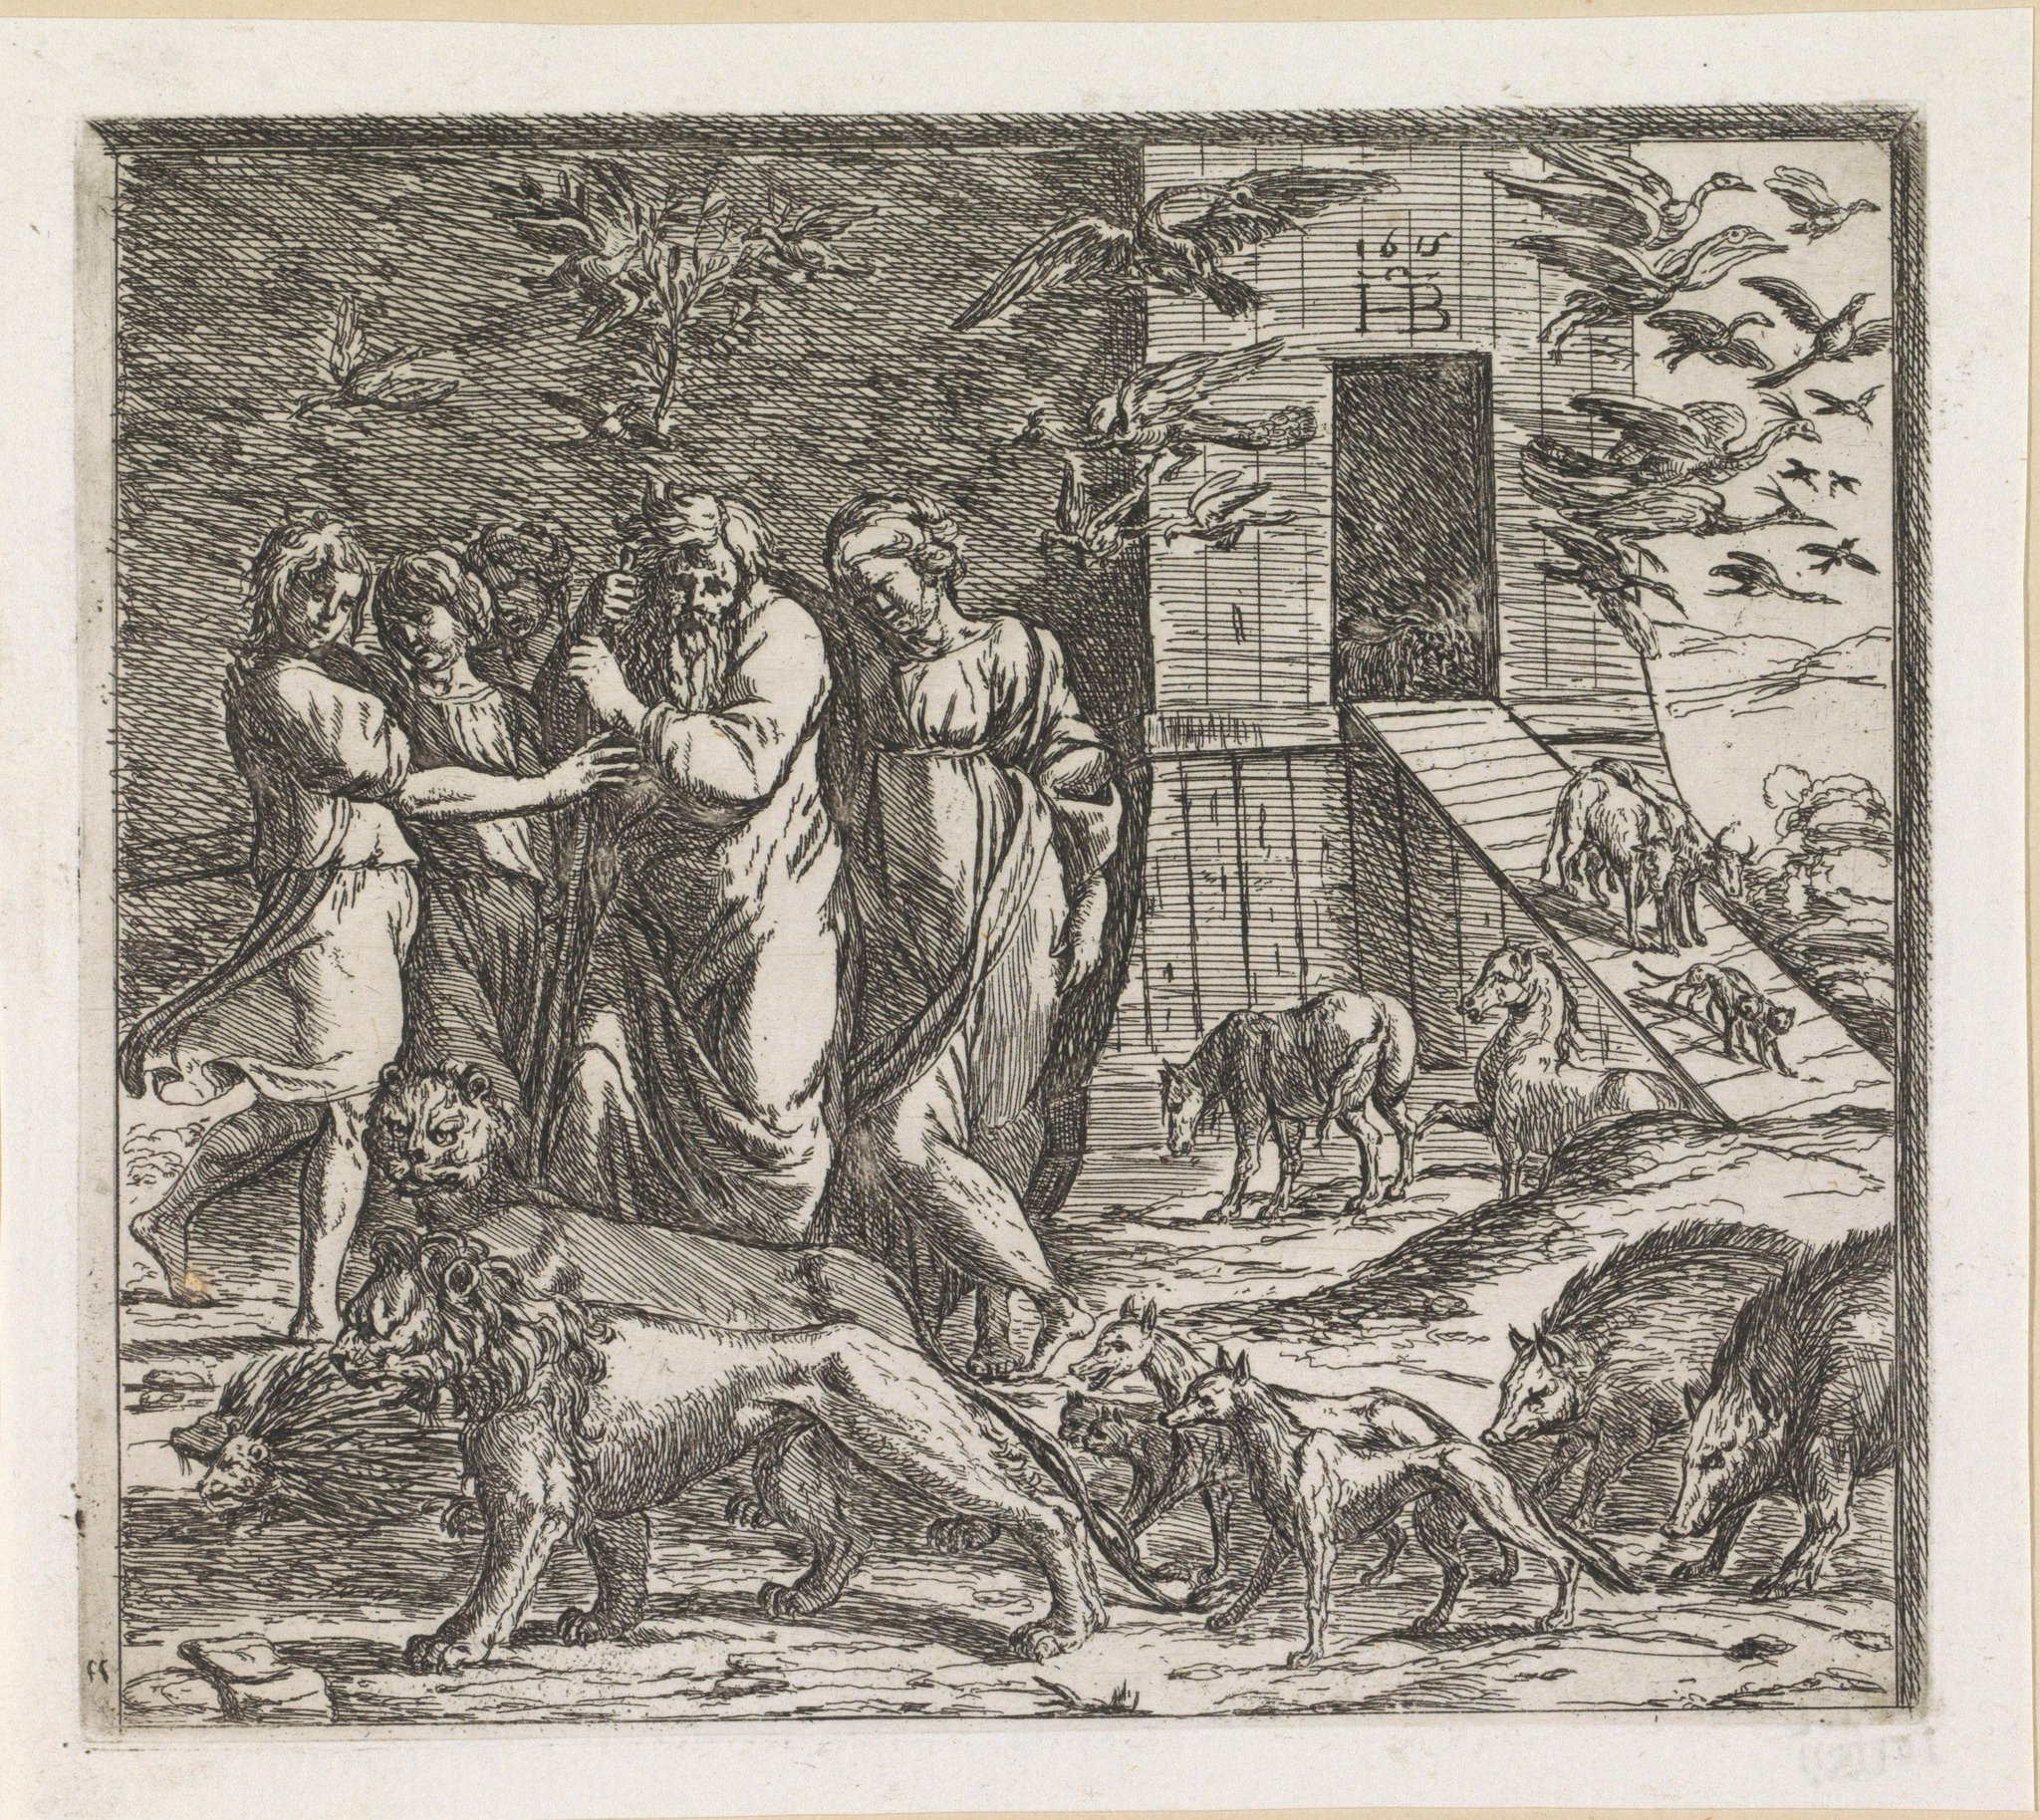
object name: print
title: Schilderingen in de Loggia van Rafaël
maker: orazio borgianni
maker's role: print maker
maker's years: 1578-1616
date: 1615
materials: paper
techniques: etching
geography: italy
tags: the disembarkation ~ story of noah (genesis 8:18 - 9:17)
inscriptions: collector's mark: Lugt 2165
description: Prent uit een reeks van 52 prenten naar schilderingen in de Loggia van Rafaël in het Vaticaan.